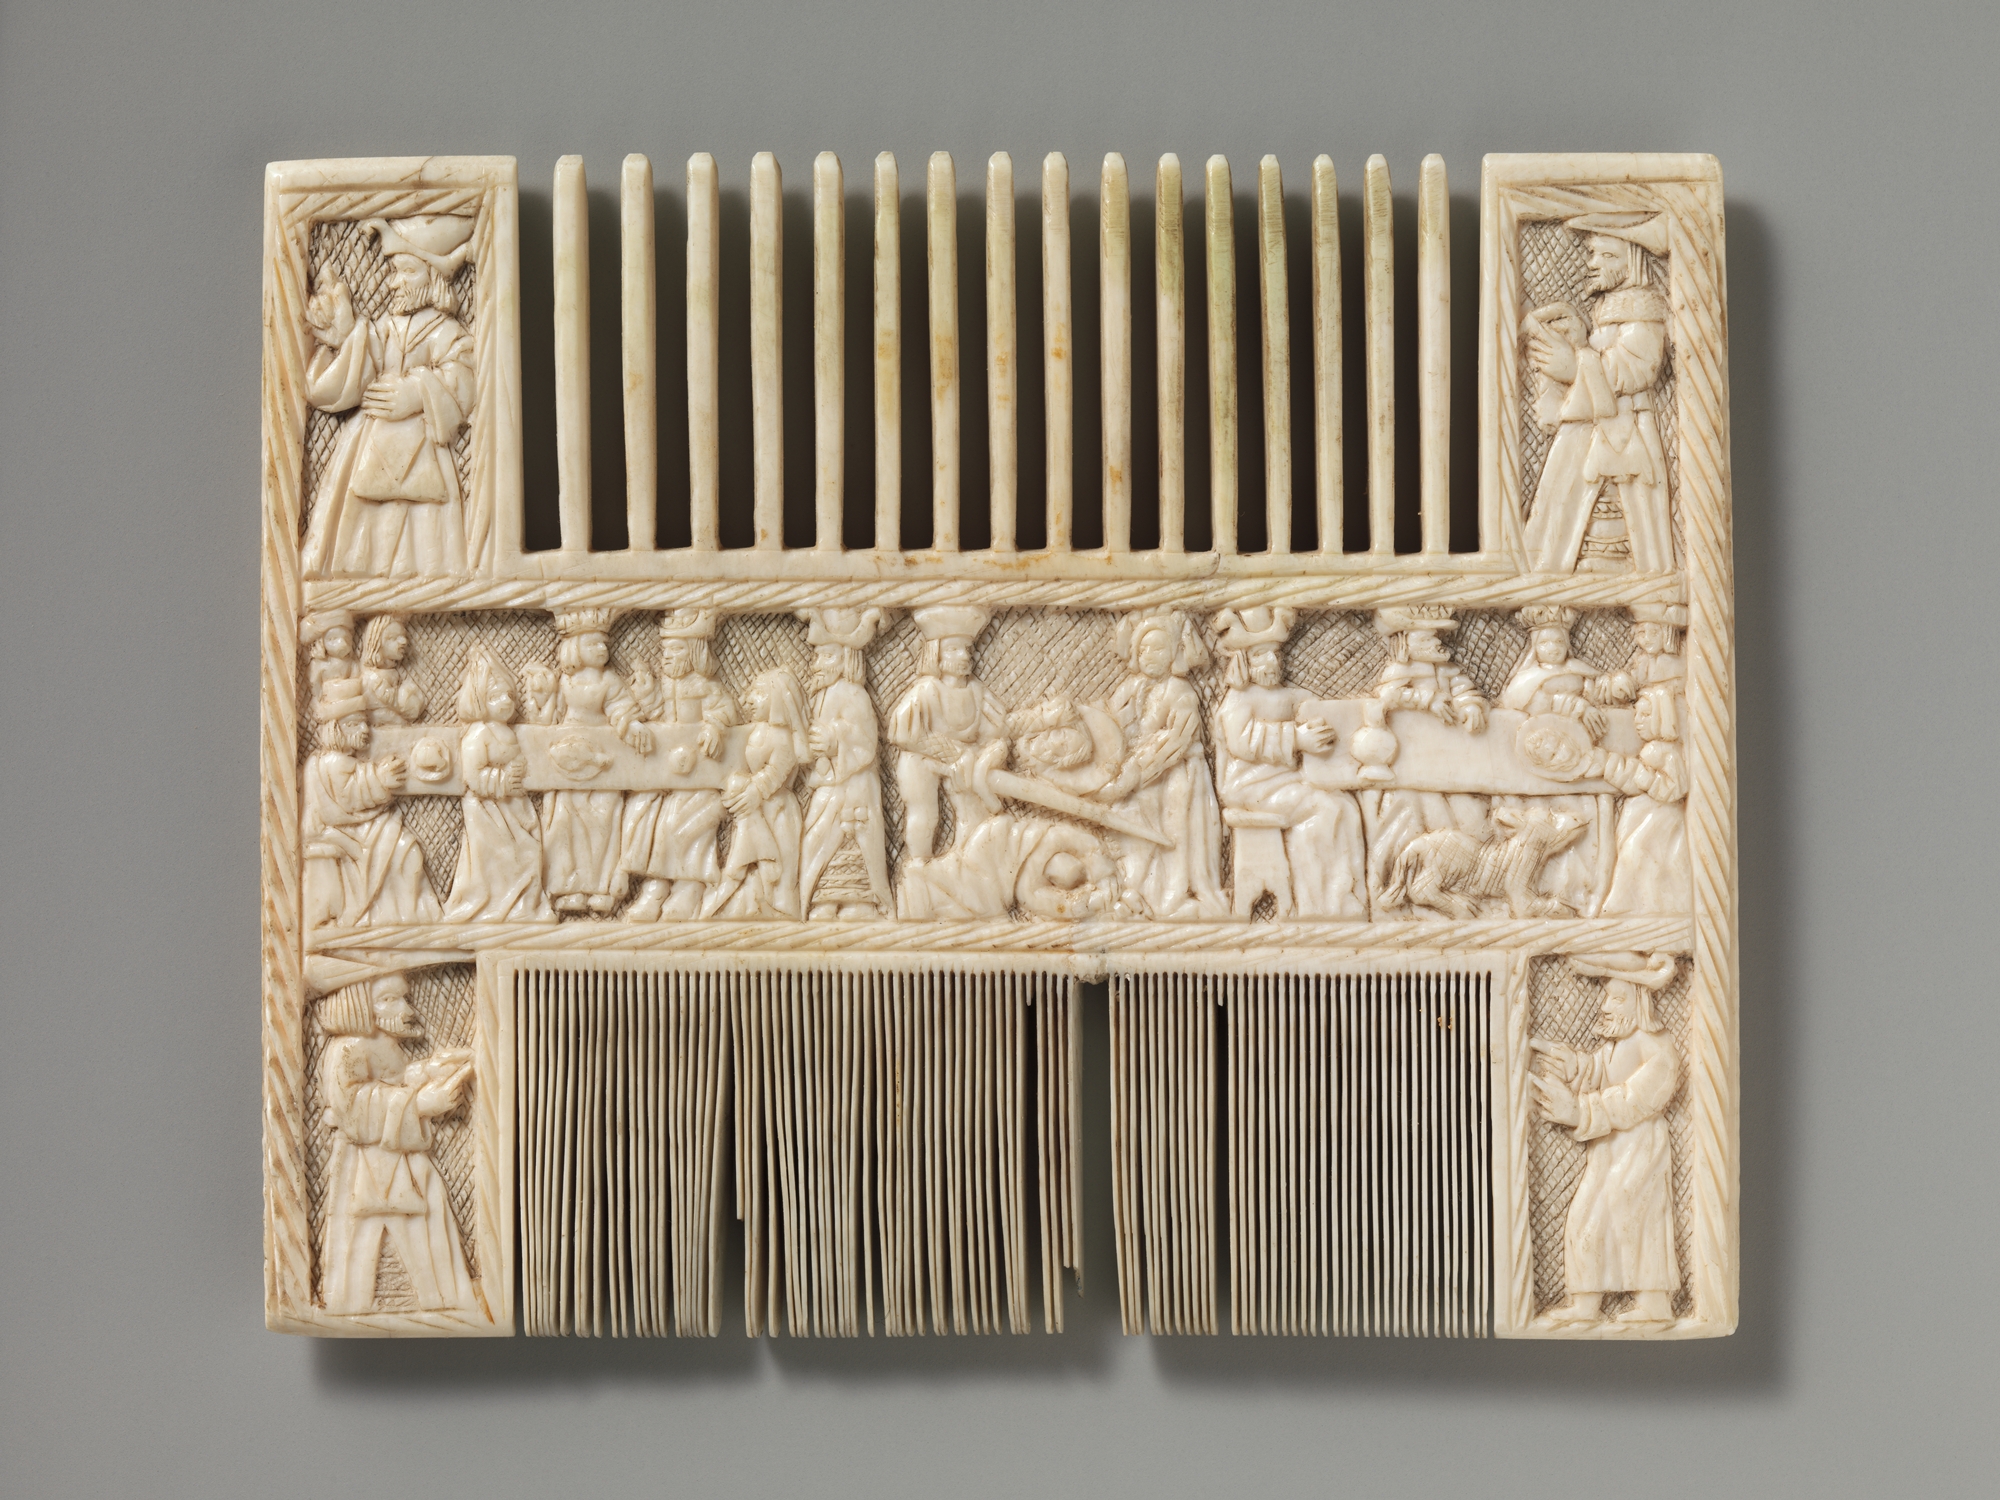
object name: comb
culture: french or dutch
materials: ivory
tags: animals,men,women,saint john the baptist,tables,herod